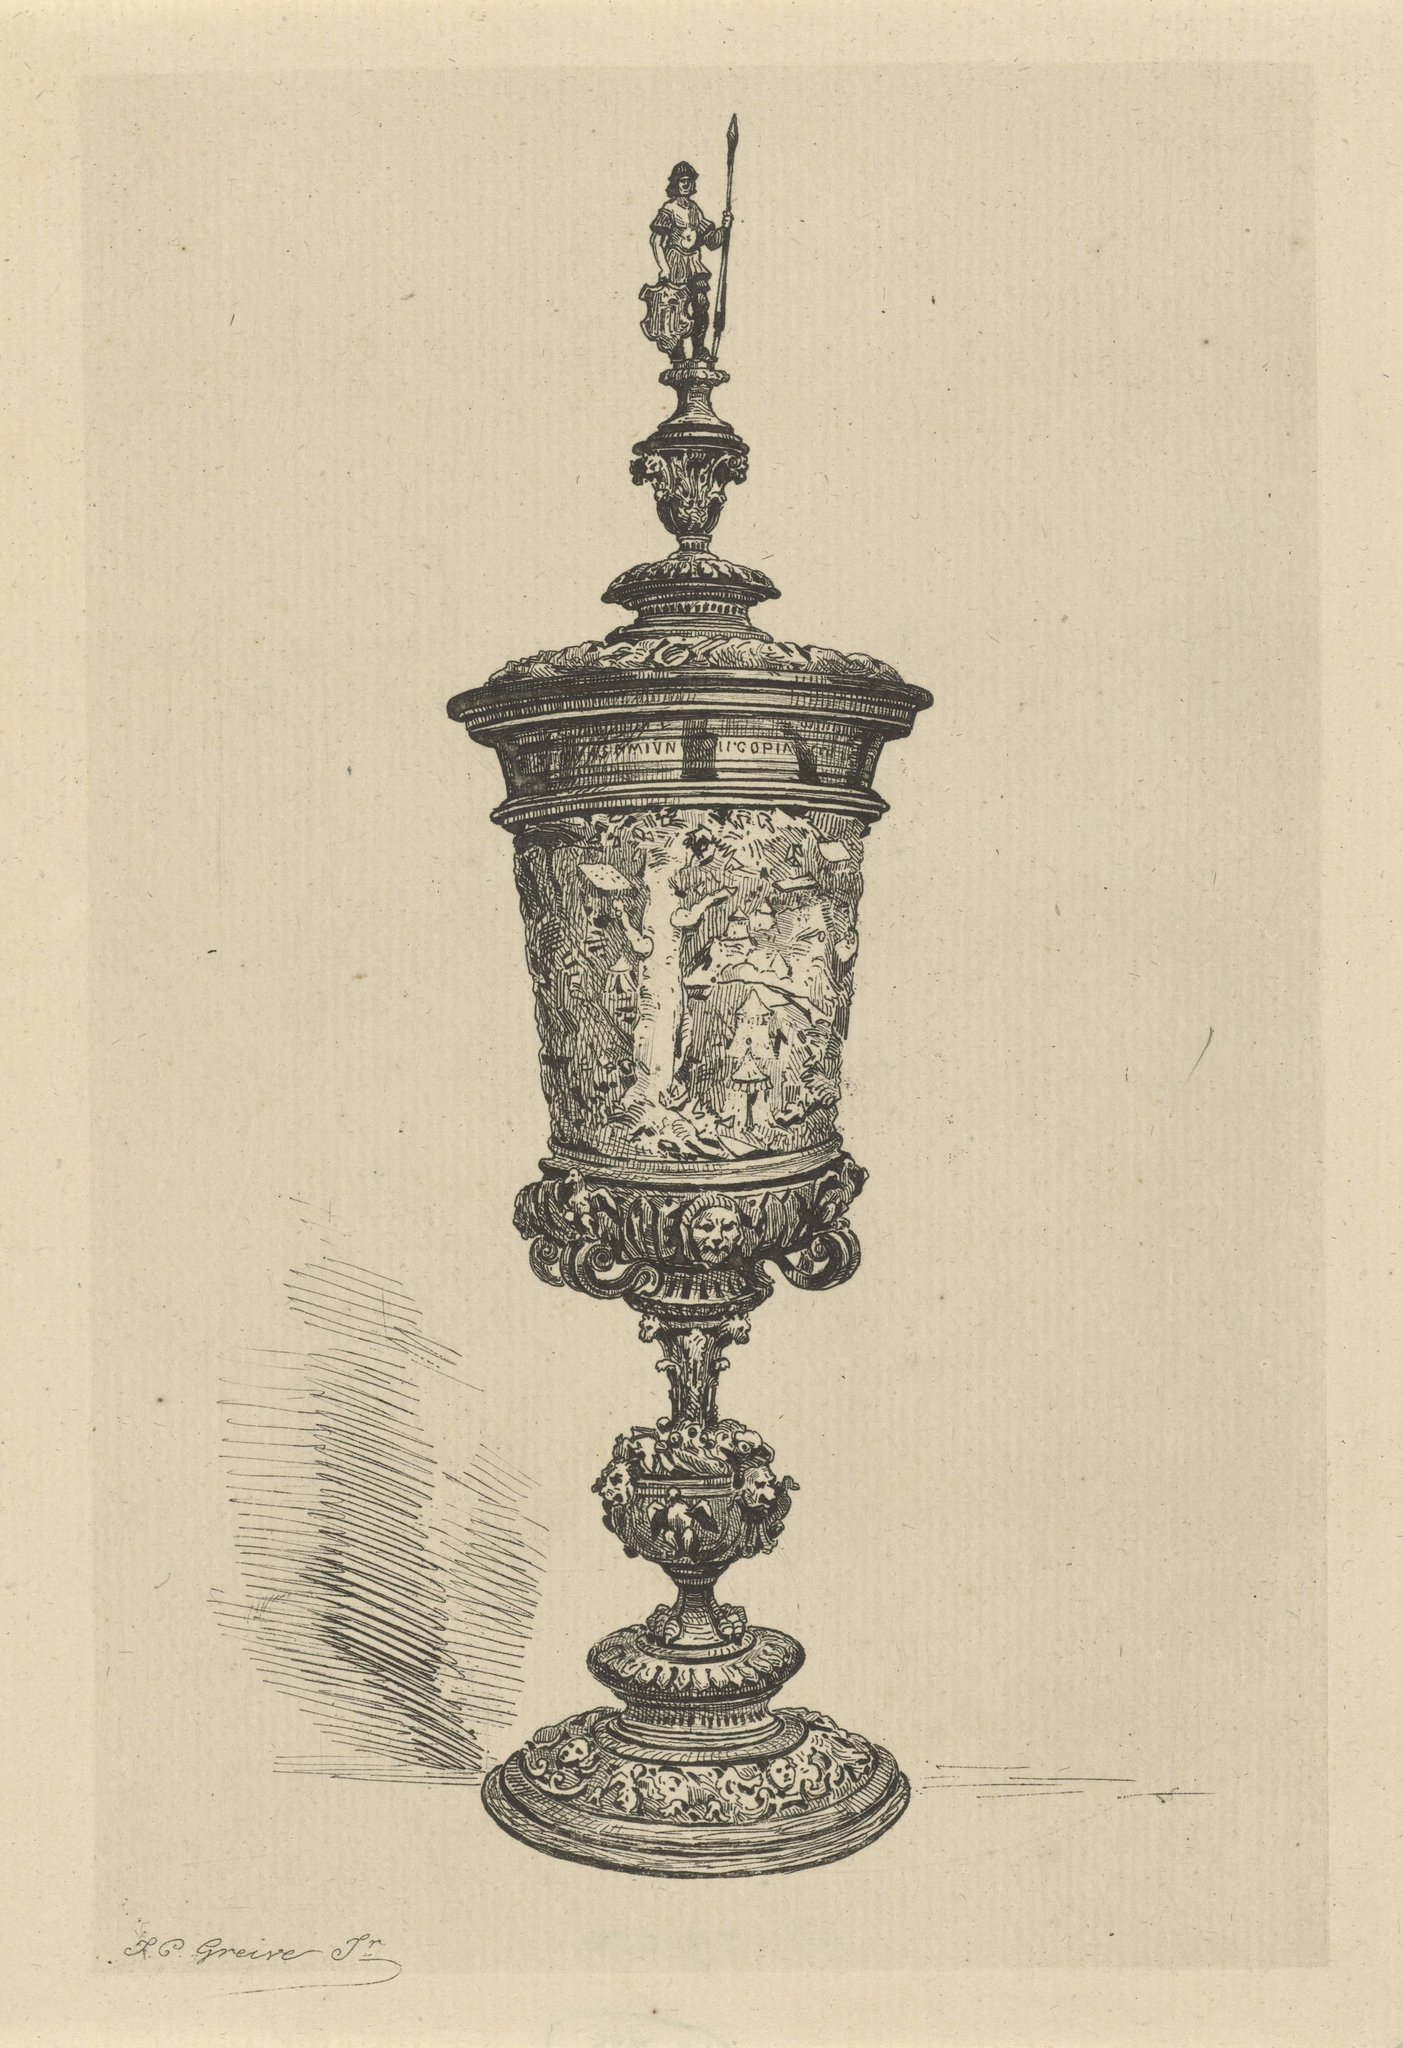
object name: print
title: Zilveren beker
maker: johan conrad greive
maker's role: draughtsman, painter, print maker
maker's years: 1837-1891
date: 1847-1891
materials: paper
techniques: etching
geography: amsterdam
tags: cup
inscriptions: collector's mark: Lugt 2228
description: Een ornamentele beker van zilver met op het deksel een voorstelling van een heilige met een speer.